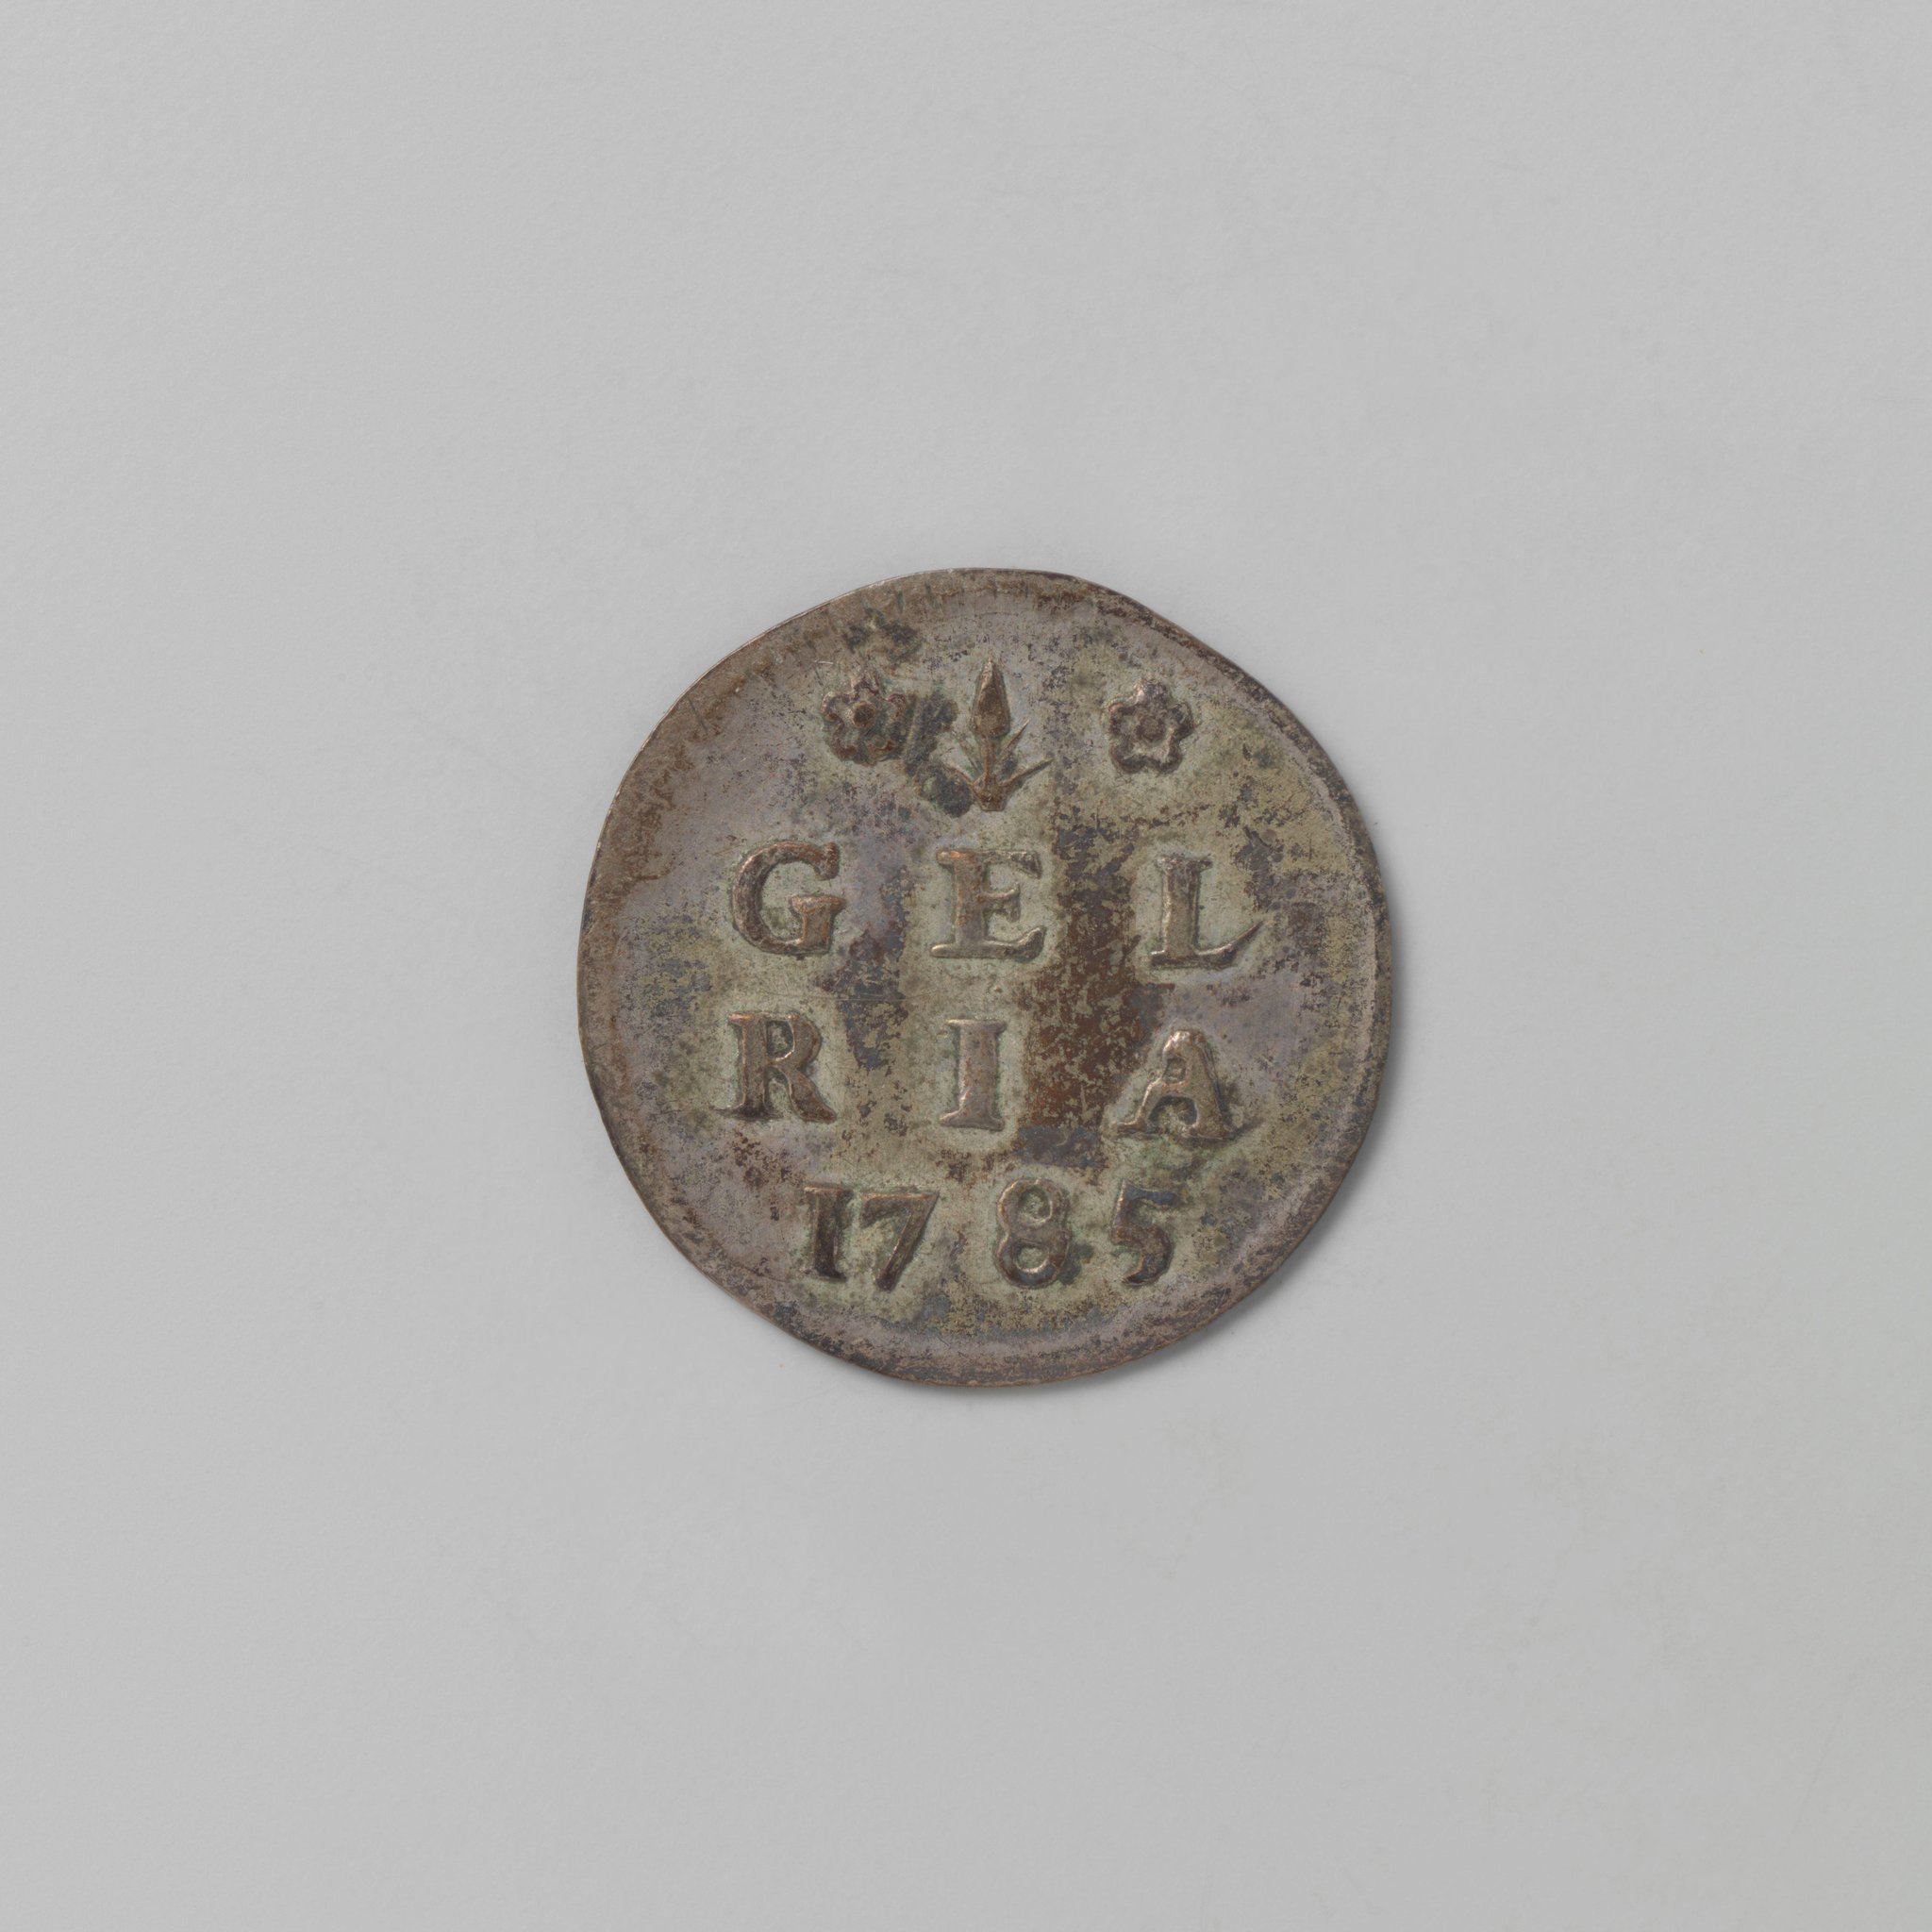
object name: coin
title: Gelderland, stuiver, 1785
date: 1785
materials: silver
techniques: striking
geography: harderwijk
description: Zilveren munt. Voorzijde: in twee regels GEL/RIA, daaronder jaartal, daarboven muntmeesterteken. Keerzijde: tussen waarde-aanduiding pijlenbundel.